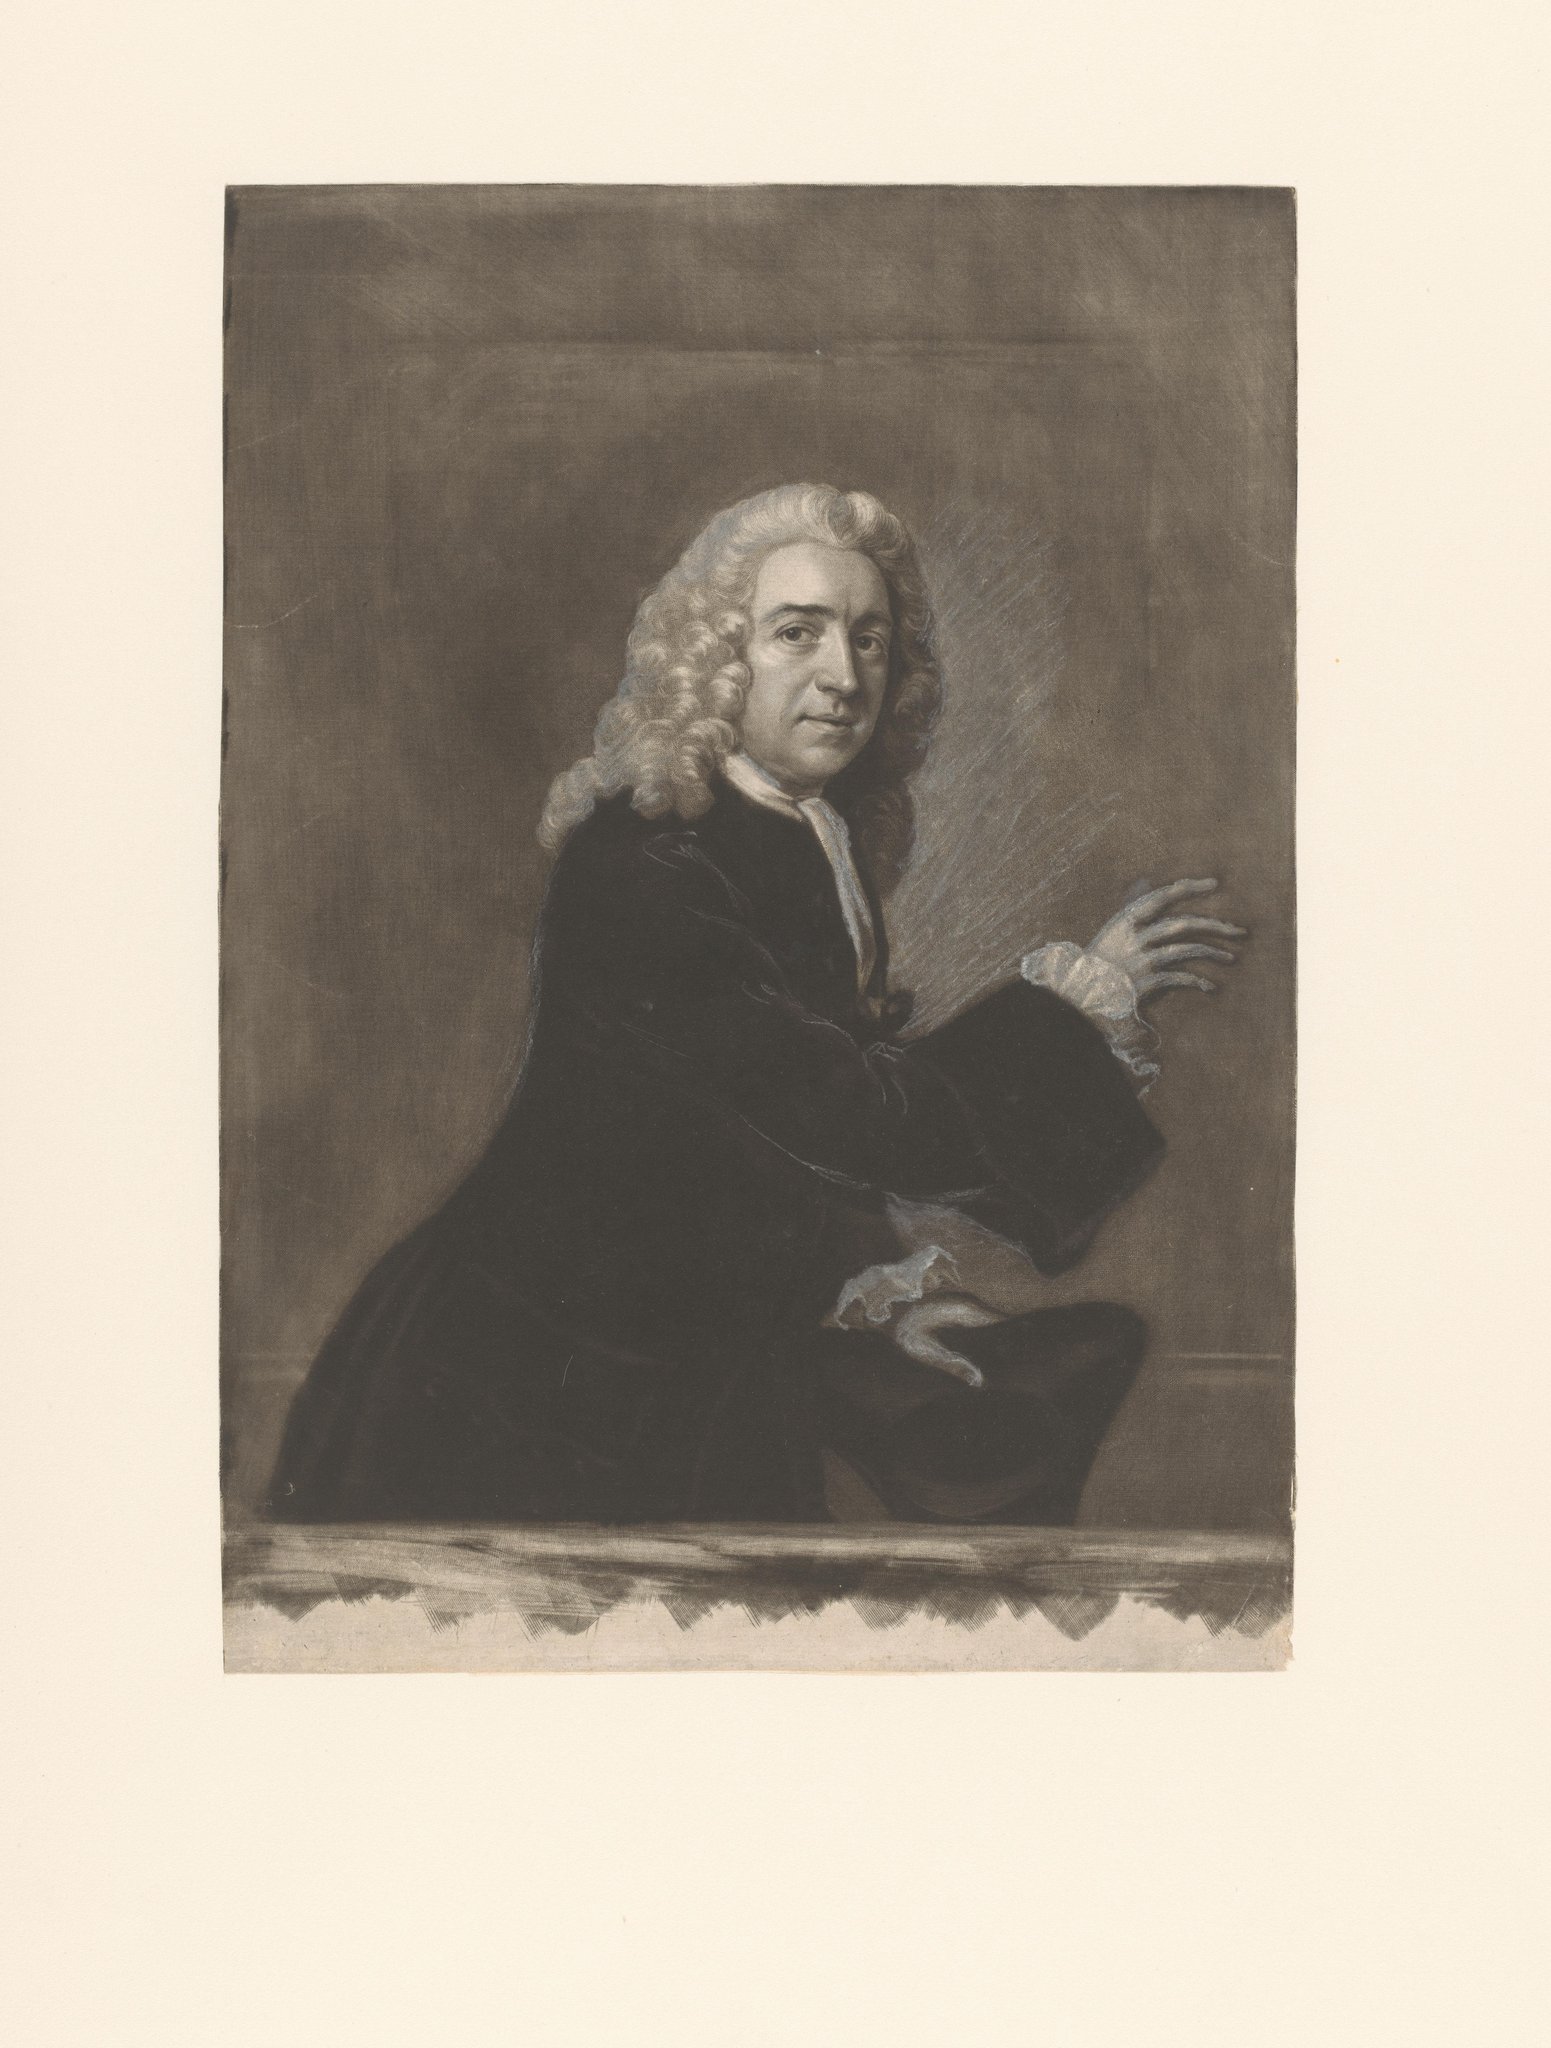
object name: print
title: Portret van David Garrick als Peter Puff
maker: james mcardell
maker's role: print maker, publisher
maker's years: 1728-1765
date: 1752-1765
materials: paint, paper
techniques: brush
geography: london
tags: london, david garrick, historical persons, portrait of actor, actress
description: Garrick in het karakter van Peter Puff uit Samuel Footes 'Taste'.